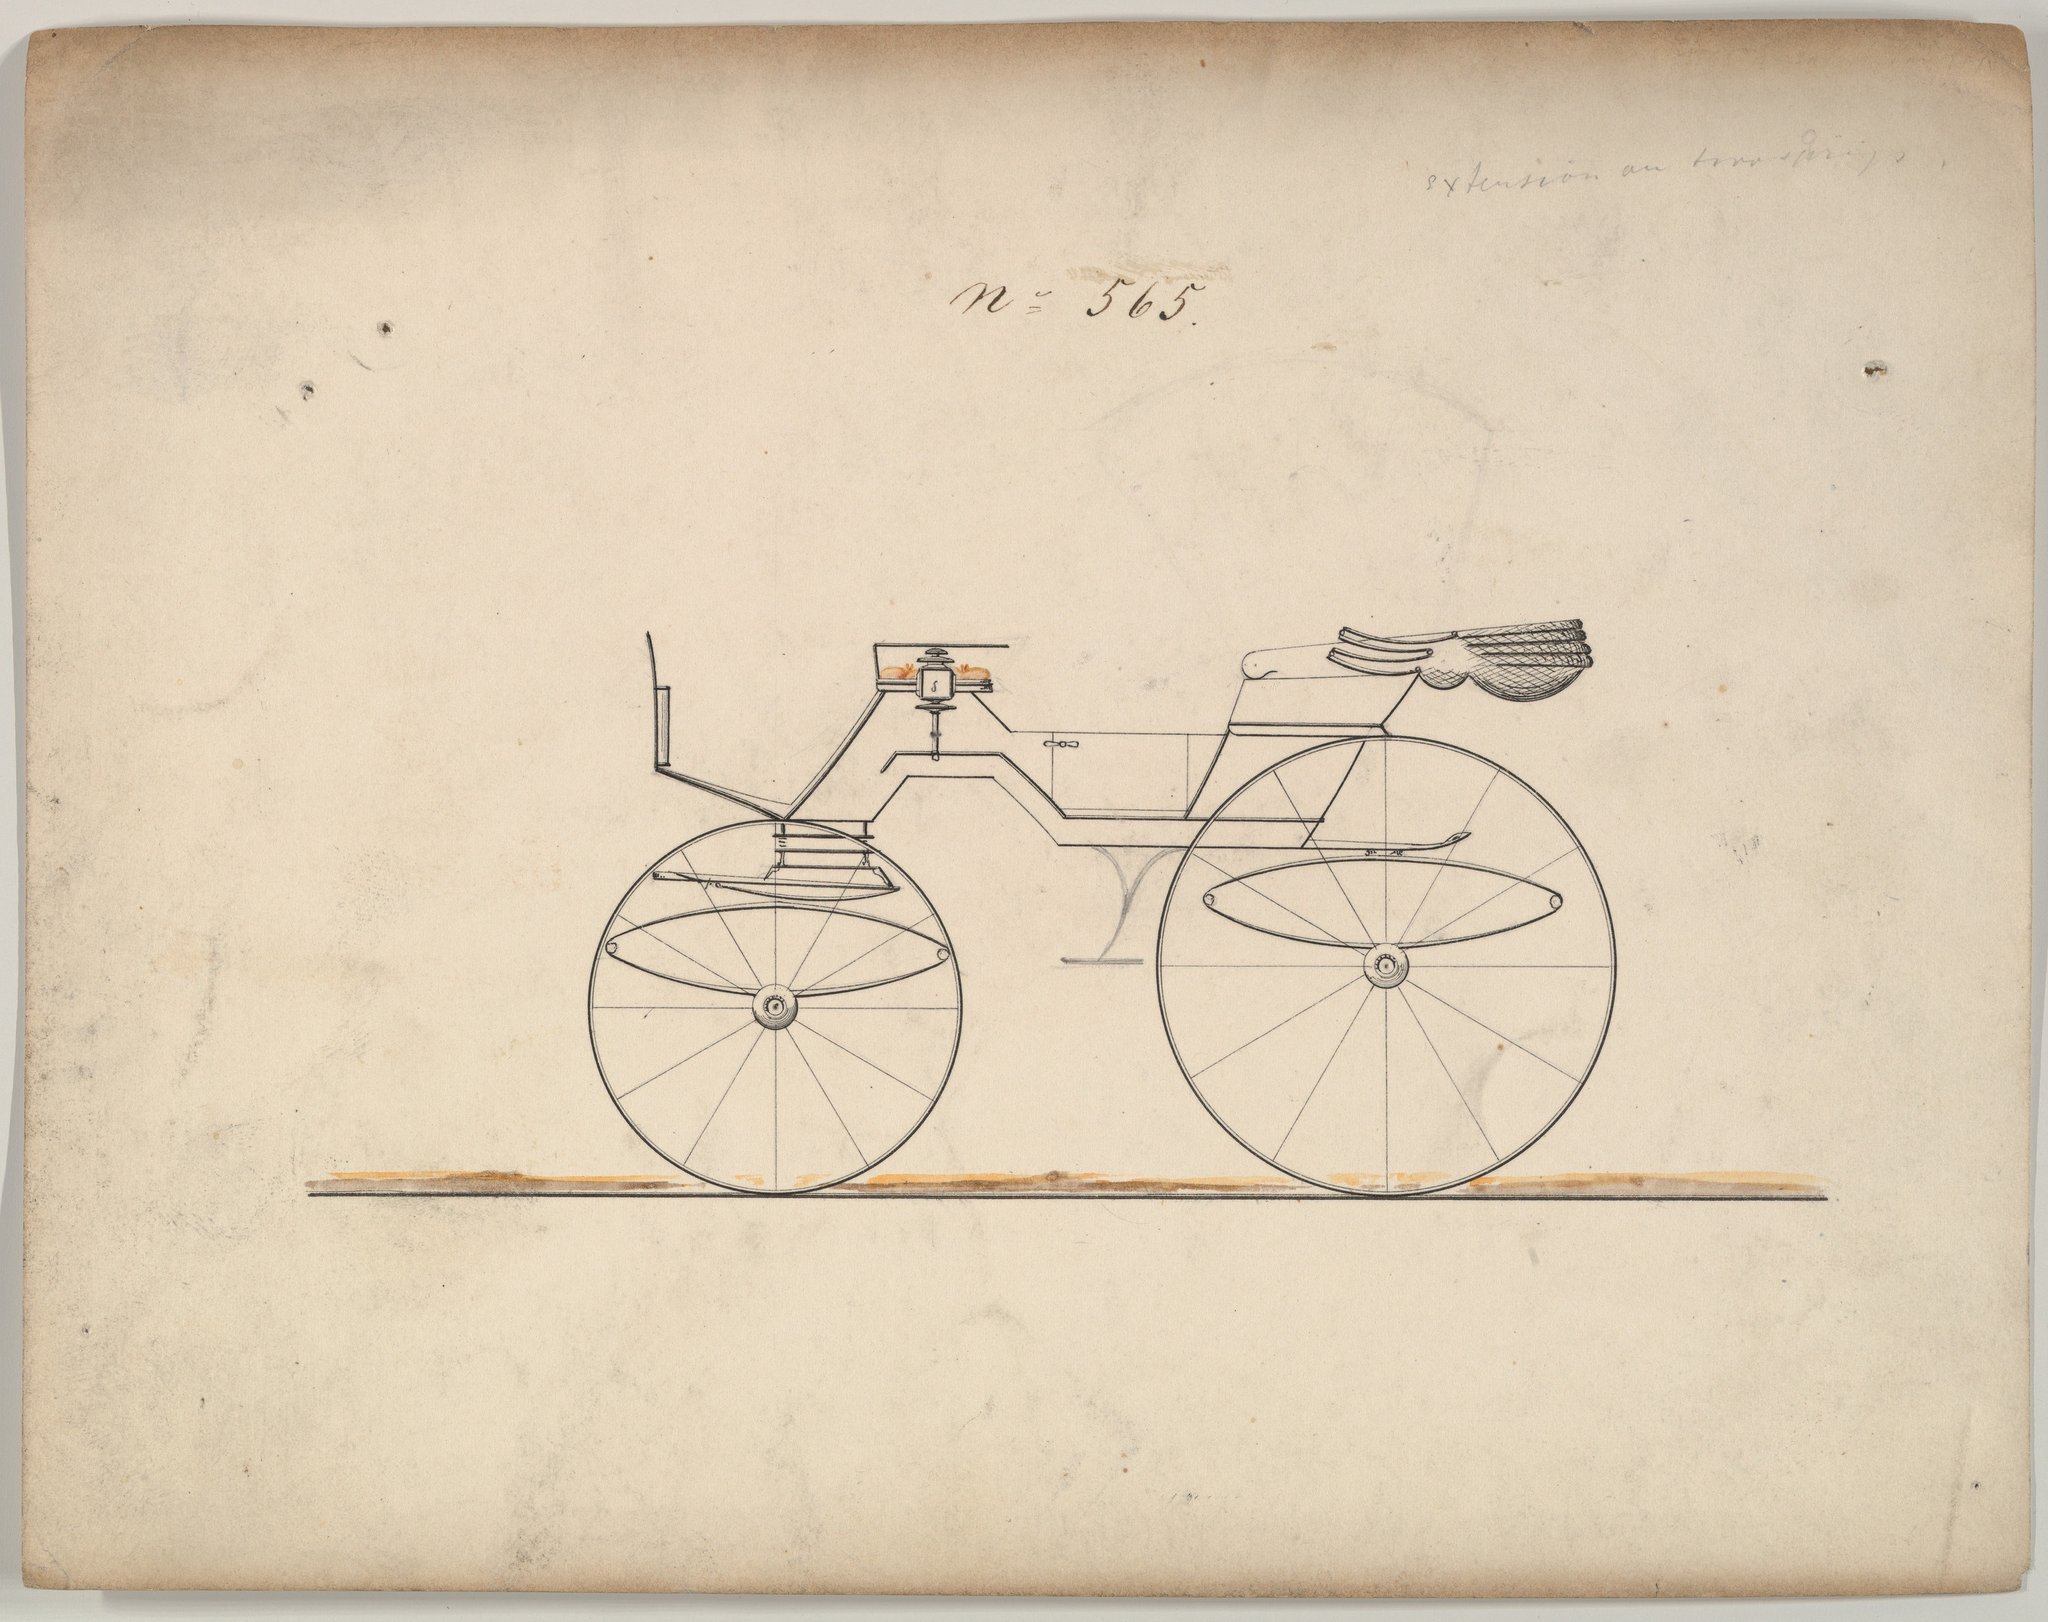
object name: drawing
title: Design for Phaeton, no. 565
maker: brewster & co.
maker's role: manufacturer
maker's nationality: american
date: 1850-1874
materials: gouache, graphite, ink, watercolor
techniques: pen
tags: carriages